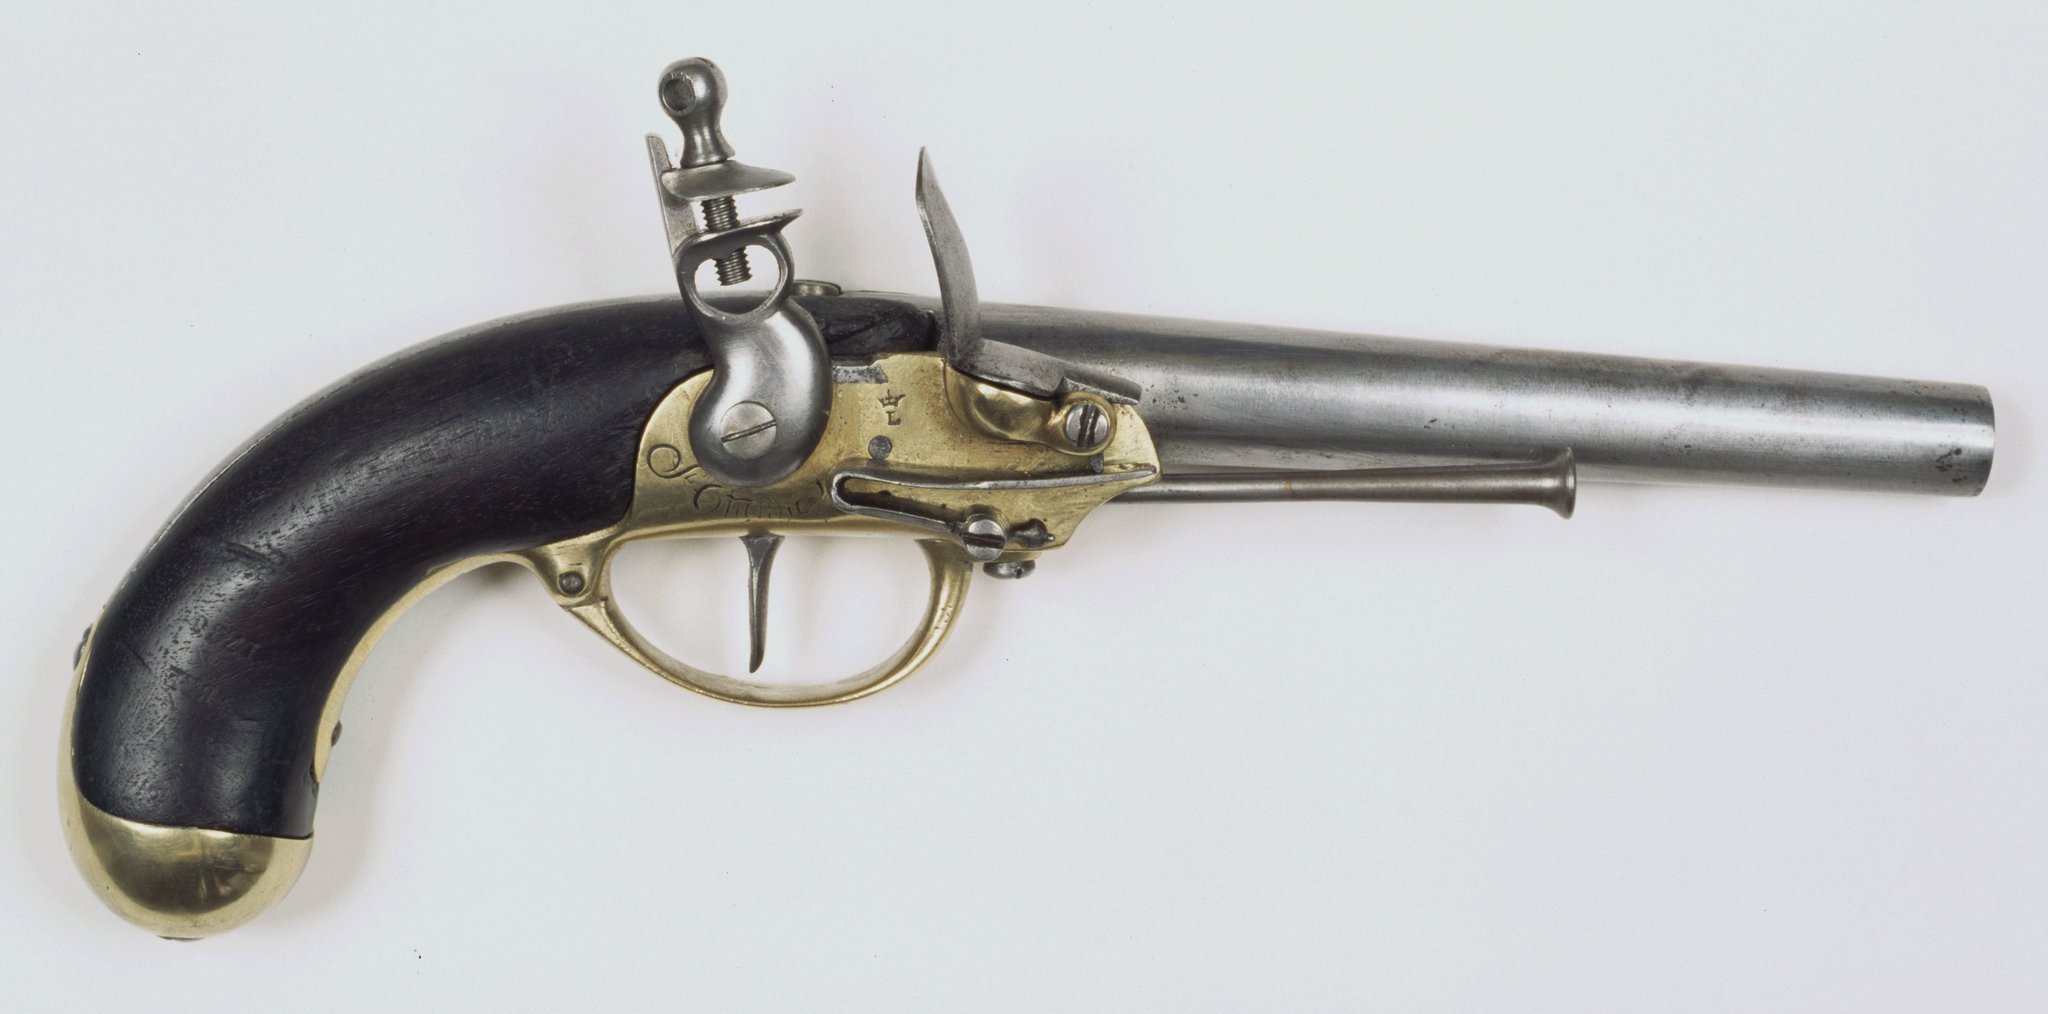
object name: flintlock pistol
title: Pistool (oud-cavalerie)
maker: Anonymous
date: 1800-1850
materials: brass, iron, wood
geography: saint-étienne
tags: netherlands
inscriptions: : ‘St. Étienne’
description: Vuursteenpistool met ronde, gladde loop. Slotplaat van messing en ijzeren haan met vuurstaal. Op de slotplaat staat 'ST. ETIENNE' en een 'L'met een kroon erboven. De kolf is van hout, de kolfkap is van messing en heeft in het midden een ijzeren schroef. Naast de loop in de slotplaat bevestigd een ijzeren laadstok in een messing koker. De trekkerbeugel is van messing en zit met twee schroeven aan de slotplaat bevestigd, de trekker is van ijzer.